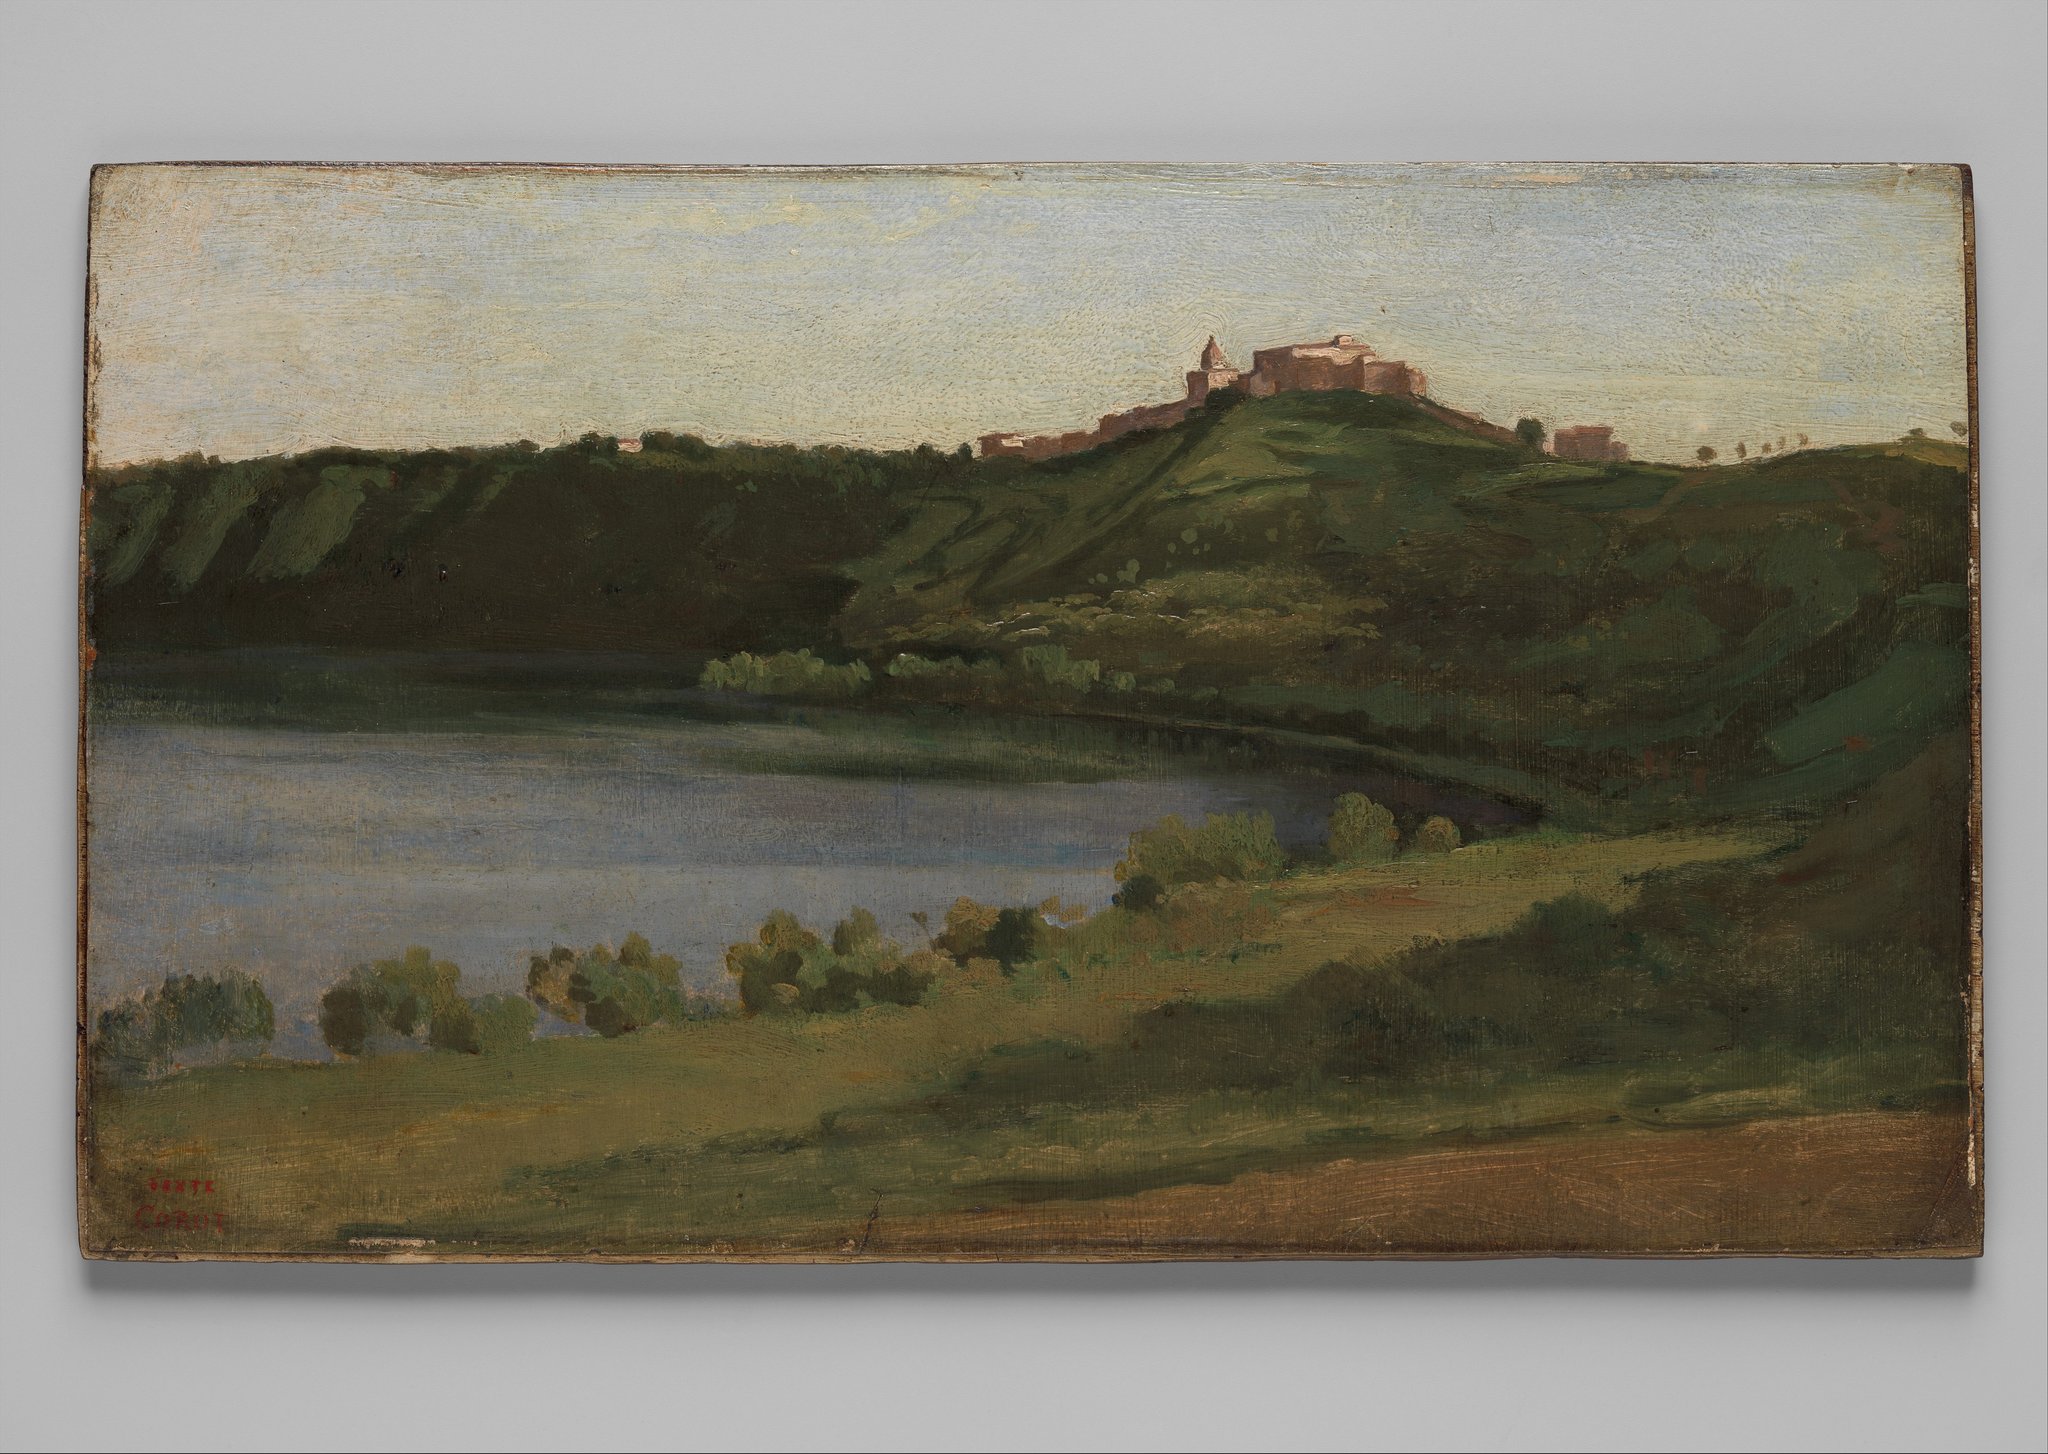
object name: drawing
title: Lake Albano and Castel Gandolfo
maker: jean-baptiste-camille corot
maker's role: artist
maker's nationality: french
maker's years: 1796-1875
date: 1826-1827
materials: oil, paper, wood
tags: lakes,landscapes